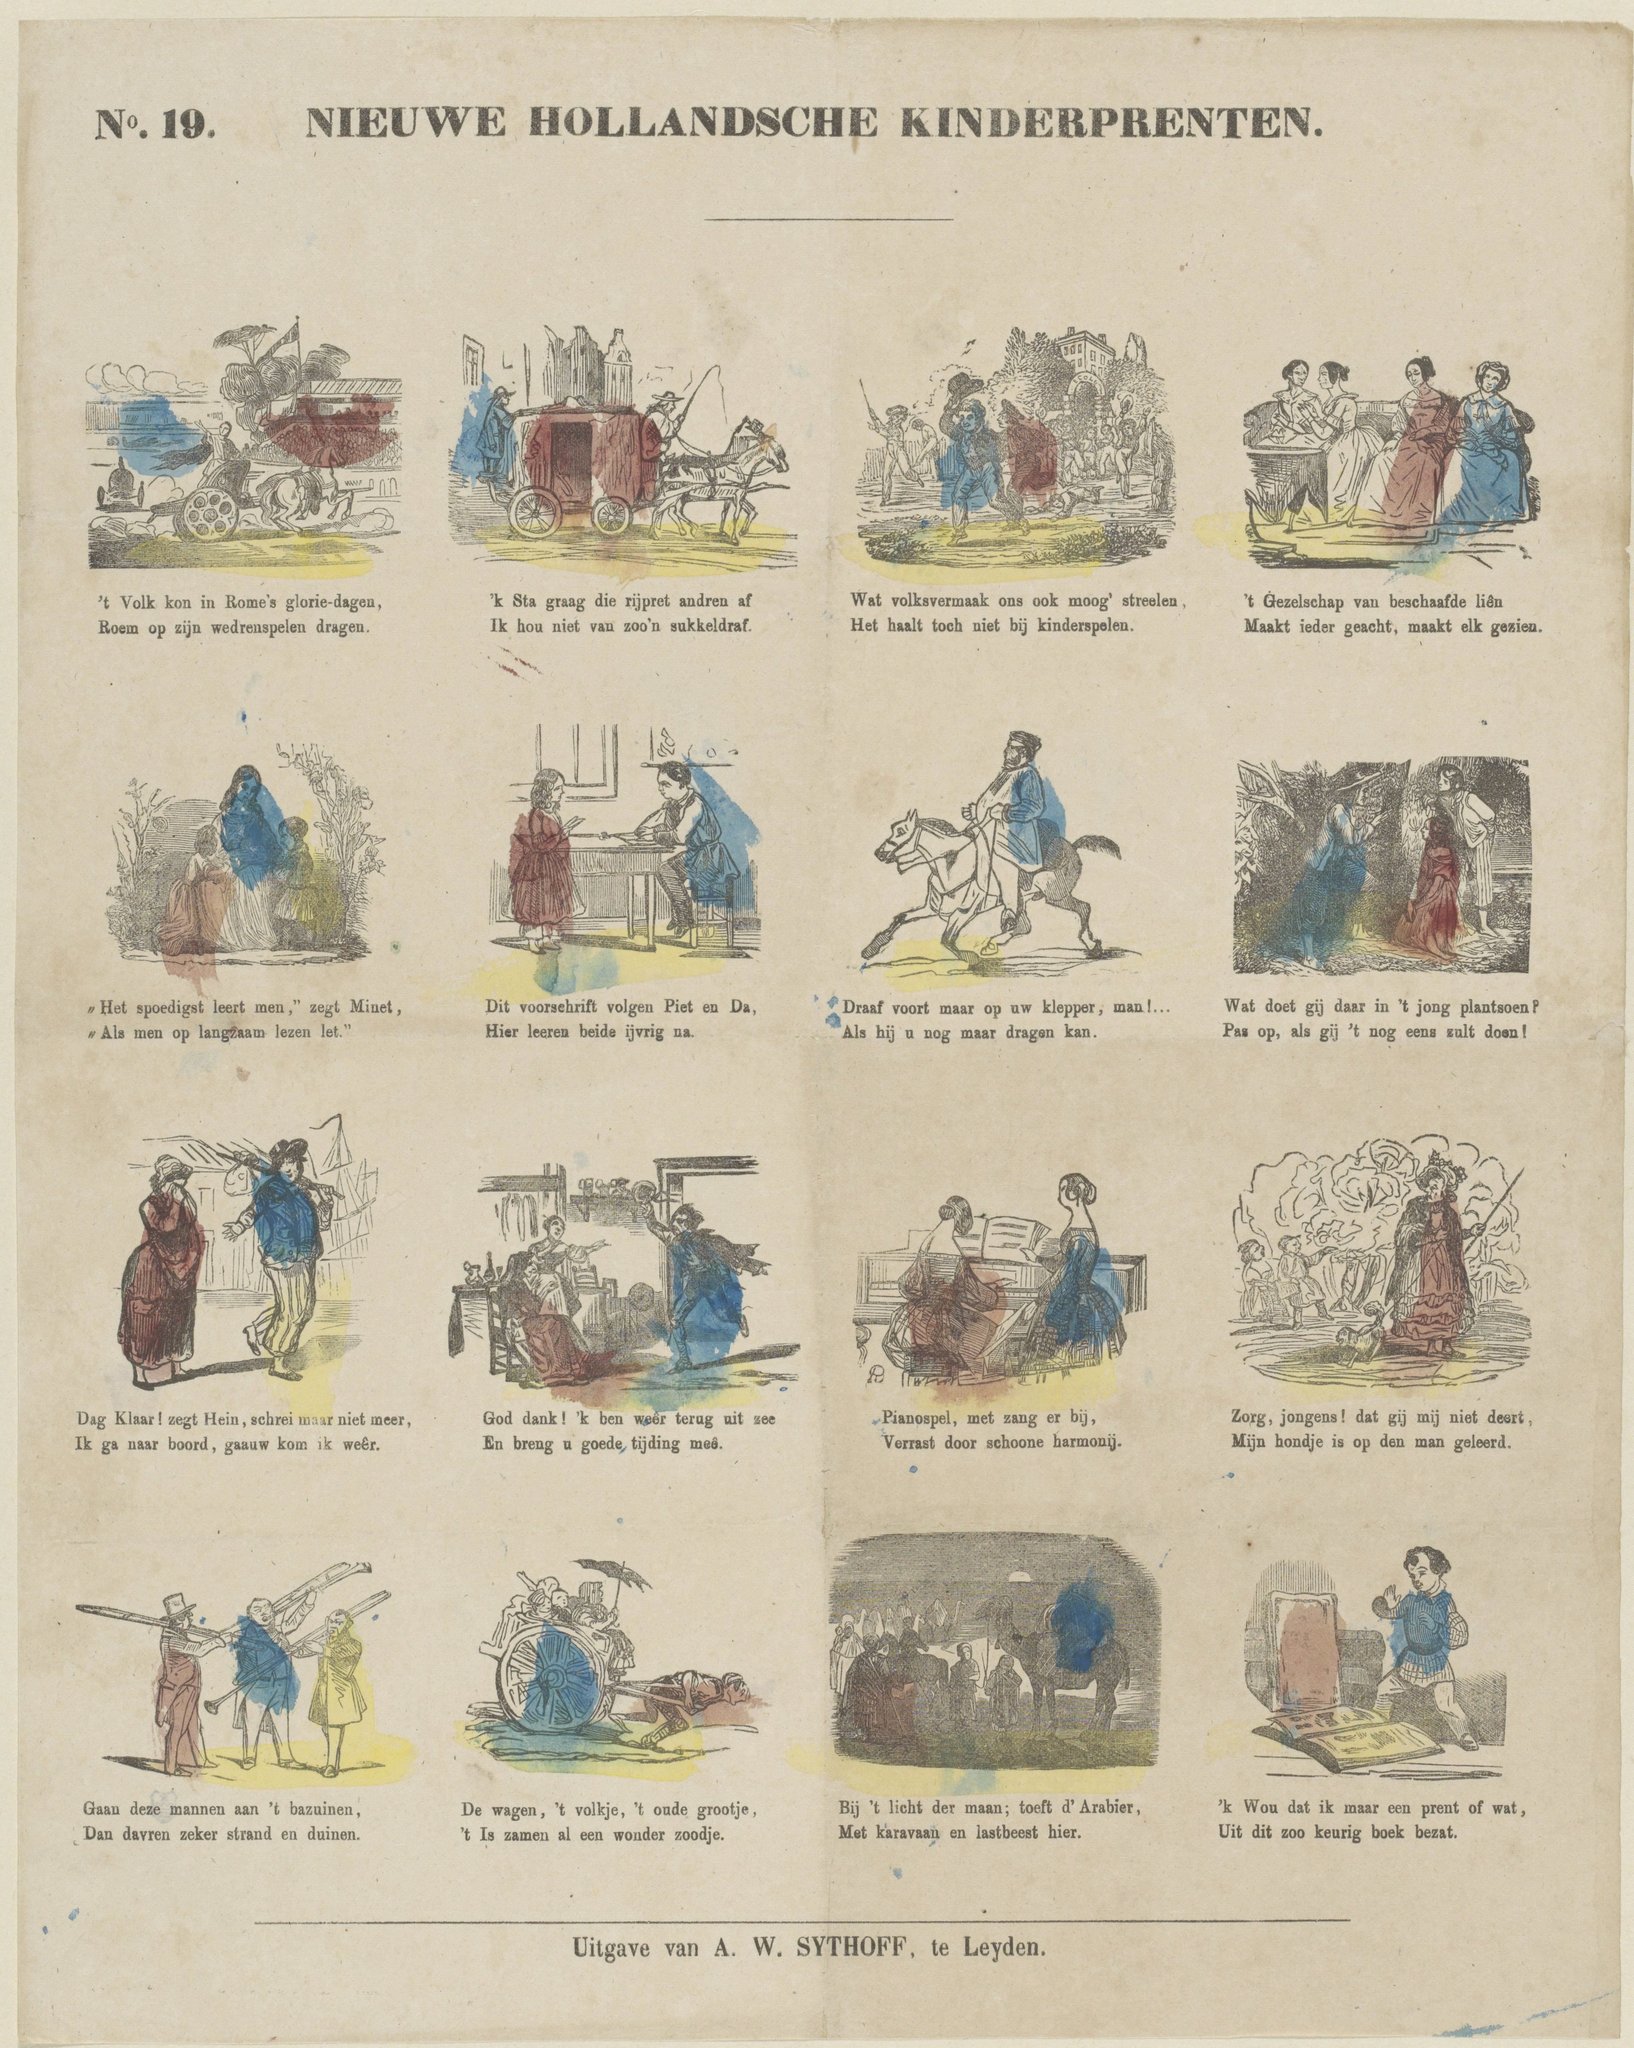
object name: print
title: Nieuwe Hollandsche kinderprenten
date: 1861-1929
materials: paper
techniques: colour, letterpress printing, engraving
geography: leiden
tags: wagon racing with two-wheeled vehicle, e.g.: chariot, sulky, human types, four-wheeled, animal-drawn vehicle, e.g.: cab, carriage, coach, characters (human types)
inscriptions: collector's mark: Lugt 2760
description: Blad met 16 voorstellingen van verschillende aard, zoals voorstellingen van wagenrennen, van een koets, van studerende kinderen en van mannen met schuiftrompetten. Onder elke voorstelling een tweeregelig vers. Genummerd linksboven: No. 19.